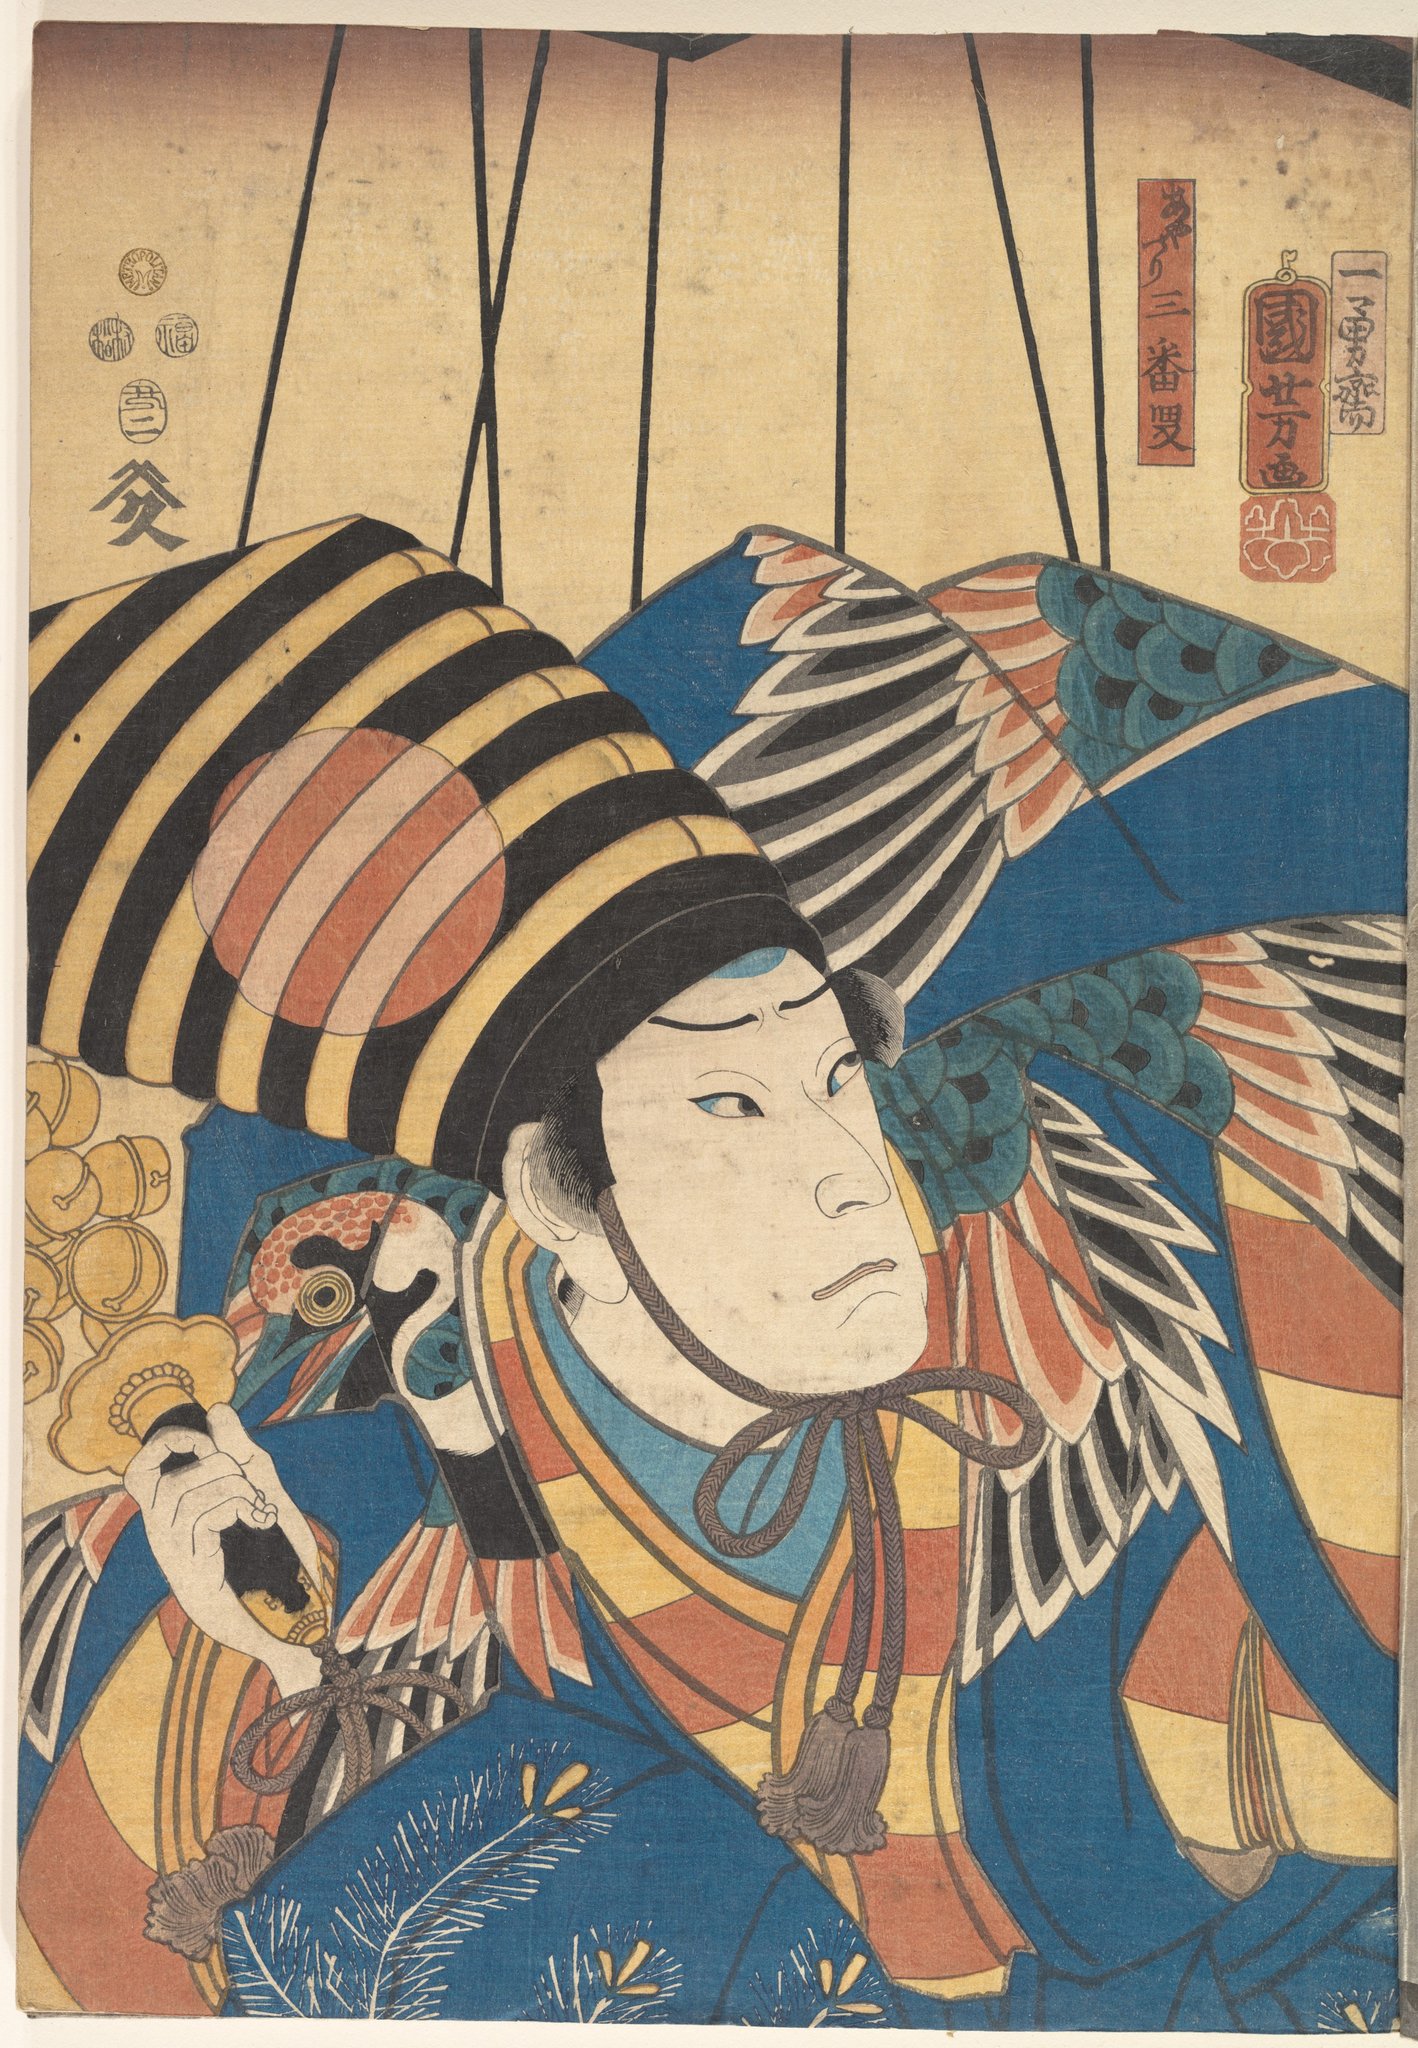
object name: print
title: Ghosts and Battle Scenes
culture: japanese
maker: utagawa kunisada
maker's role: artist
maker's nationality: japanese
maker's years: 1786-1864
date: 1801-1900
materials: ink, paper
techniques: woodblock print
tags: human figures,battles,weapons,landscapes